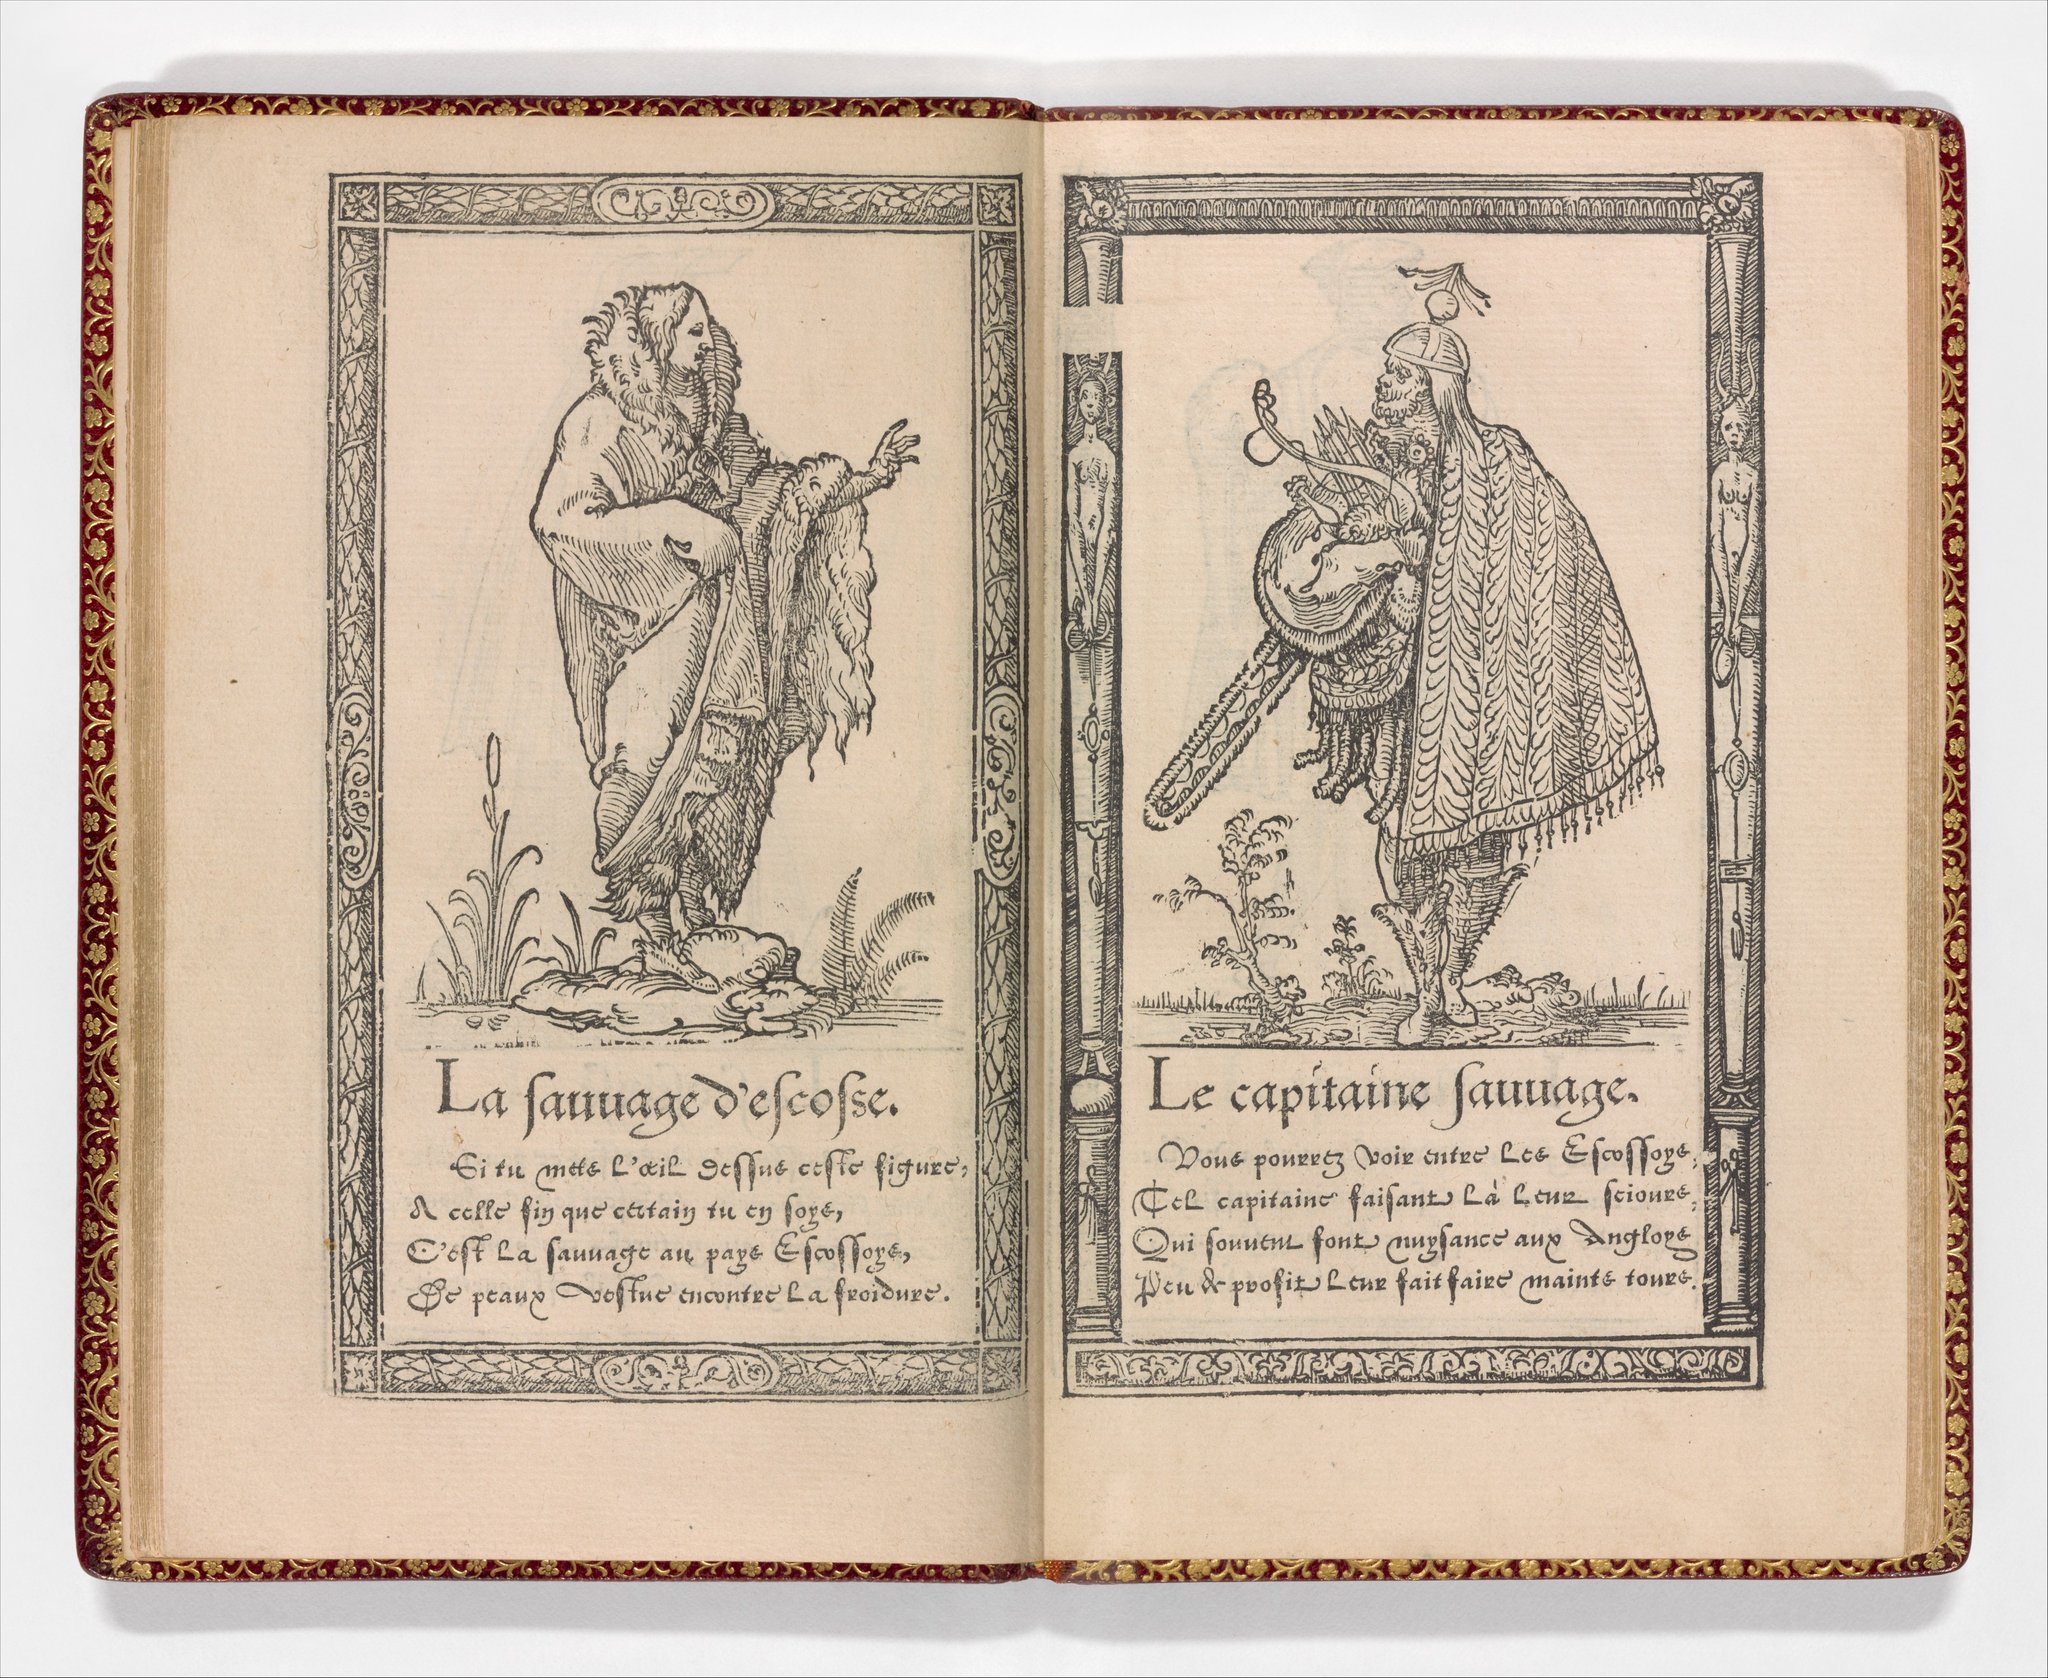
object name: book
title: Recueil de la diversité des habits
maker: françois desprez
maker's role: artist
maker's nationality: french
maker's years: 1500-1600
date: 1562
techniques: woodcut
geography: france